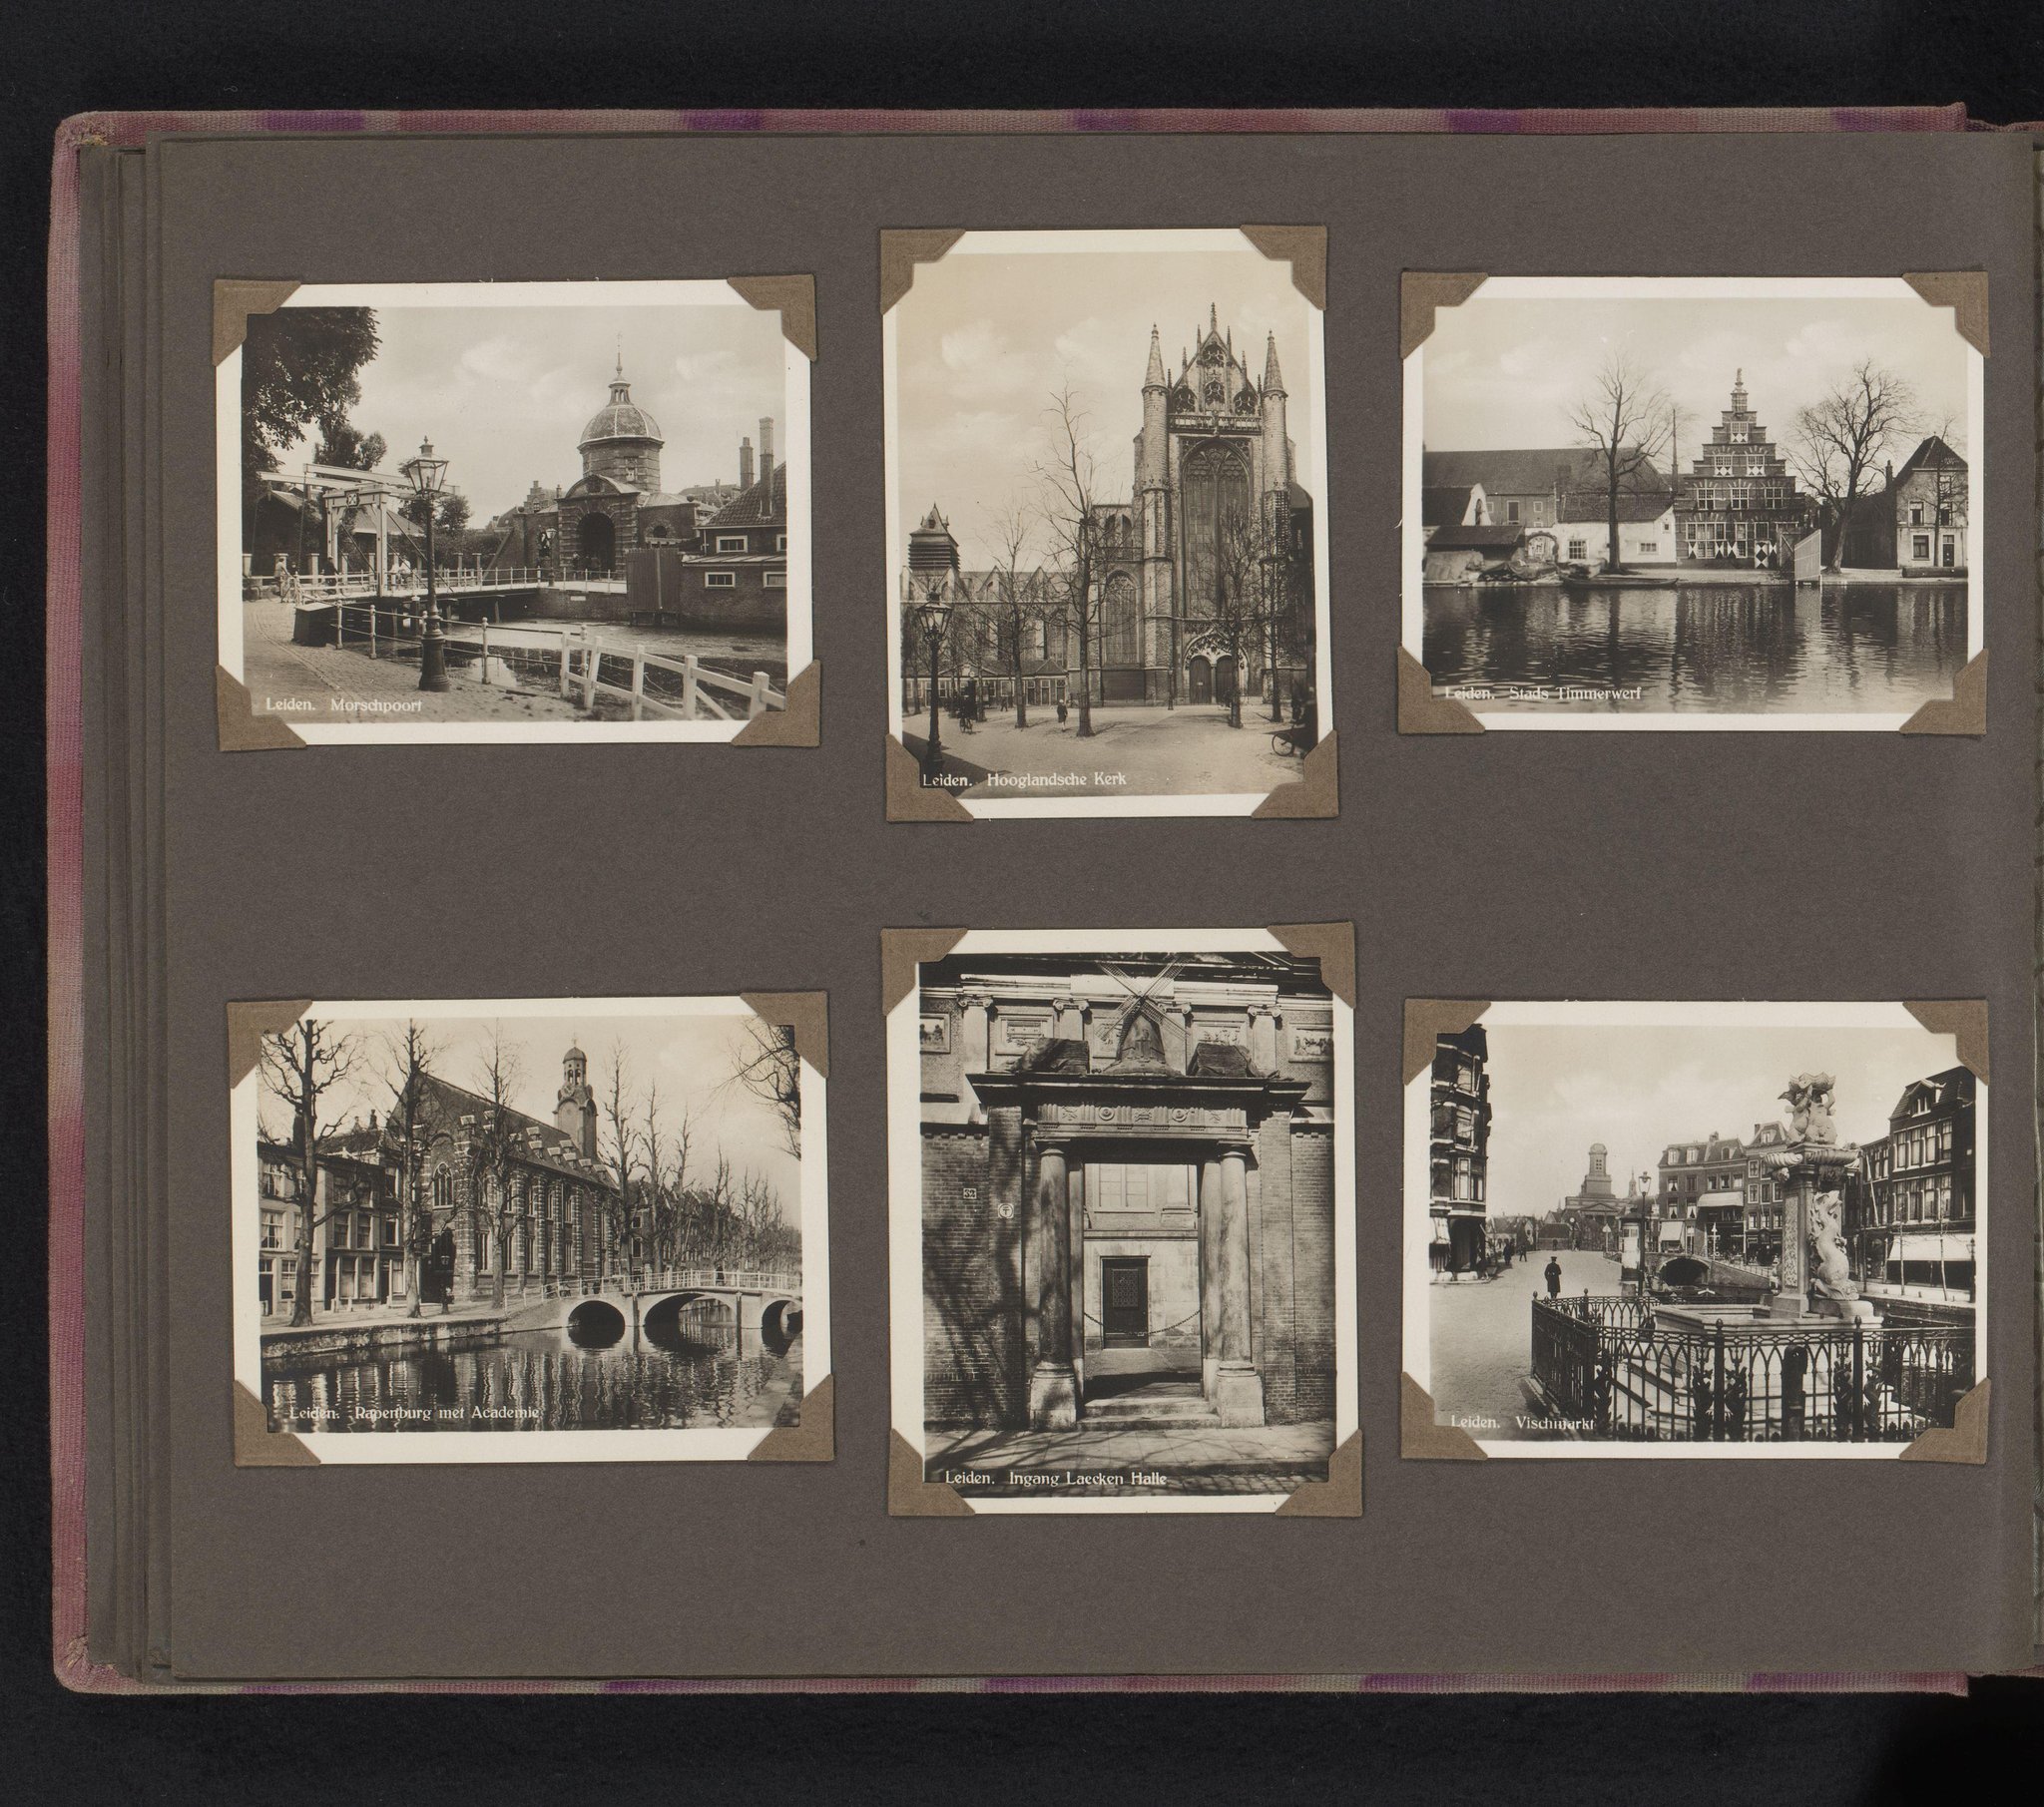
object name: photograph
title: Zes gezichten op Leiden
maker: Anonymous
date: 1930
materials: cardboard, photographic support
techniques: gelatin silver print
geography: leiden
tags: square, place, circus, etc., church (exterior), canals, waters (in city), city-gate, prospect of city, town panorama, silhouette of city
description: In de opschriften van de foto's is vermeld dat het gaat om de Morspoort, de Hooglandse kerk, de Stadstimmerwerf, het Rapenburg met Academiegebouw, de ingang van museum De Lakenhal en de Vismarkt. Deze foto's maken deel uit van een album.